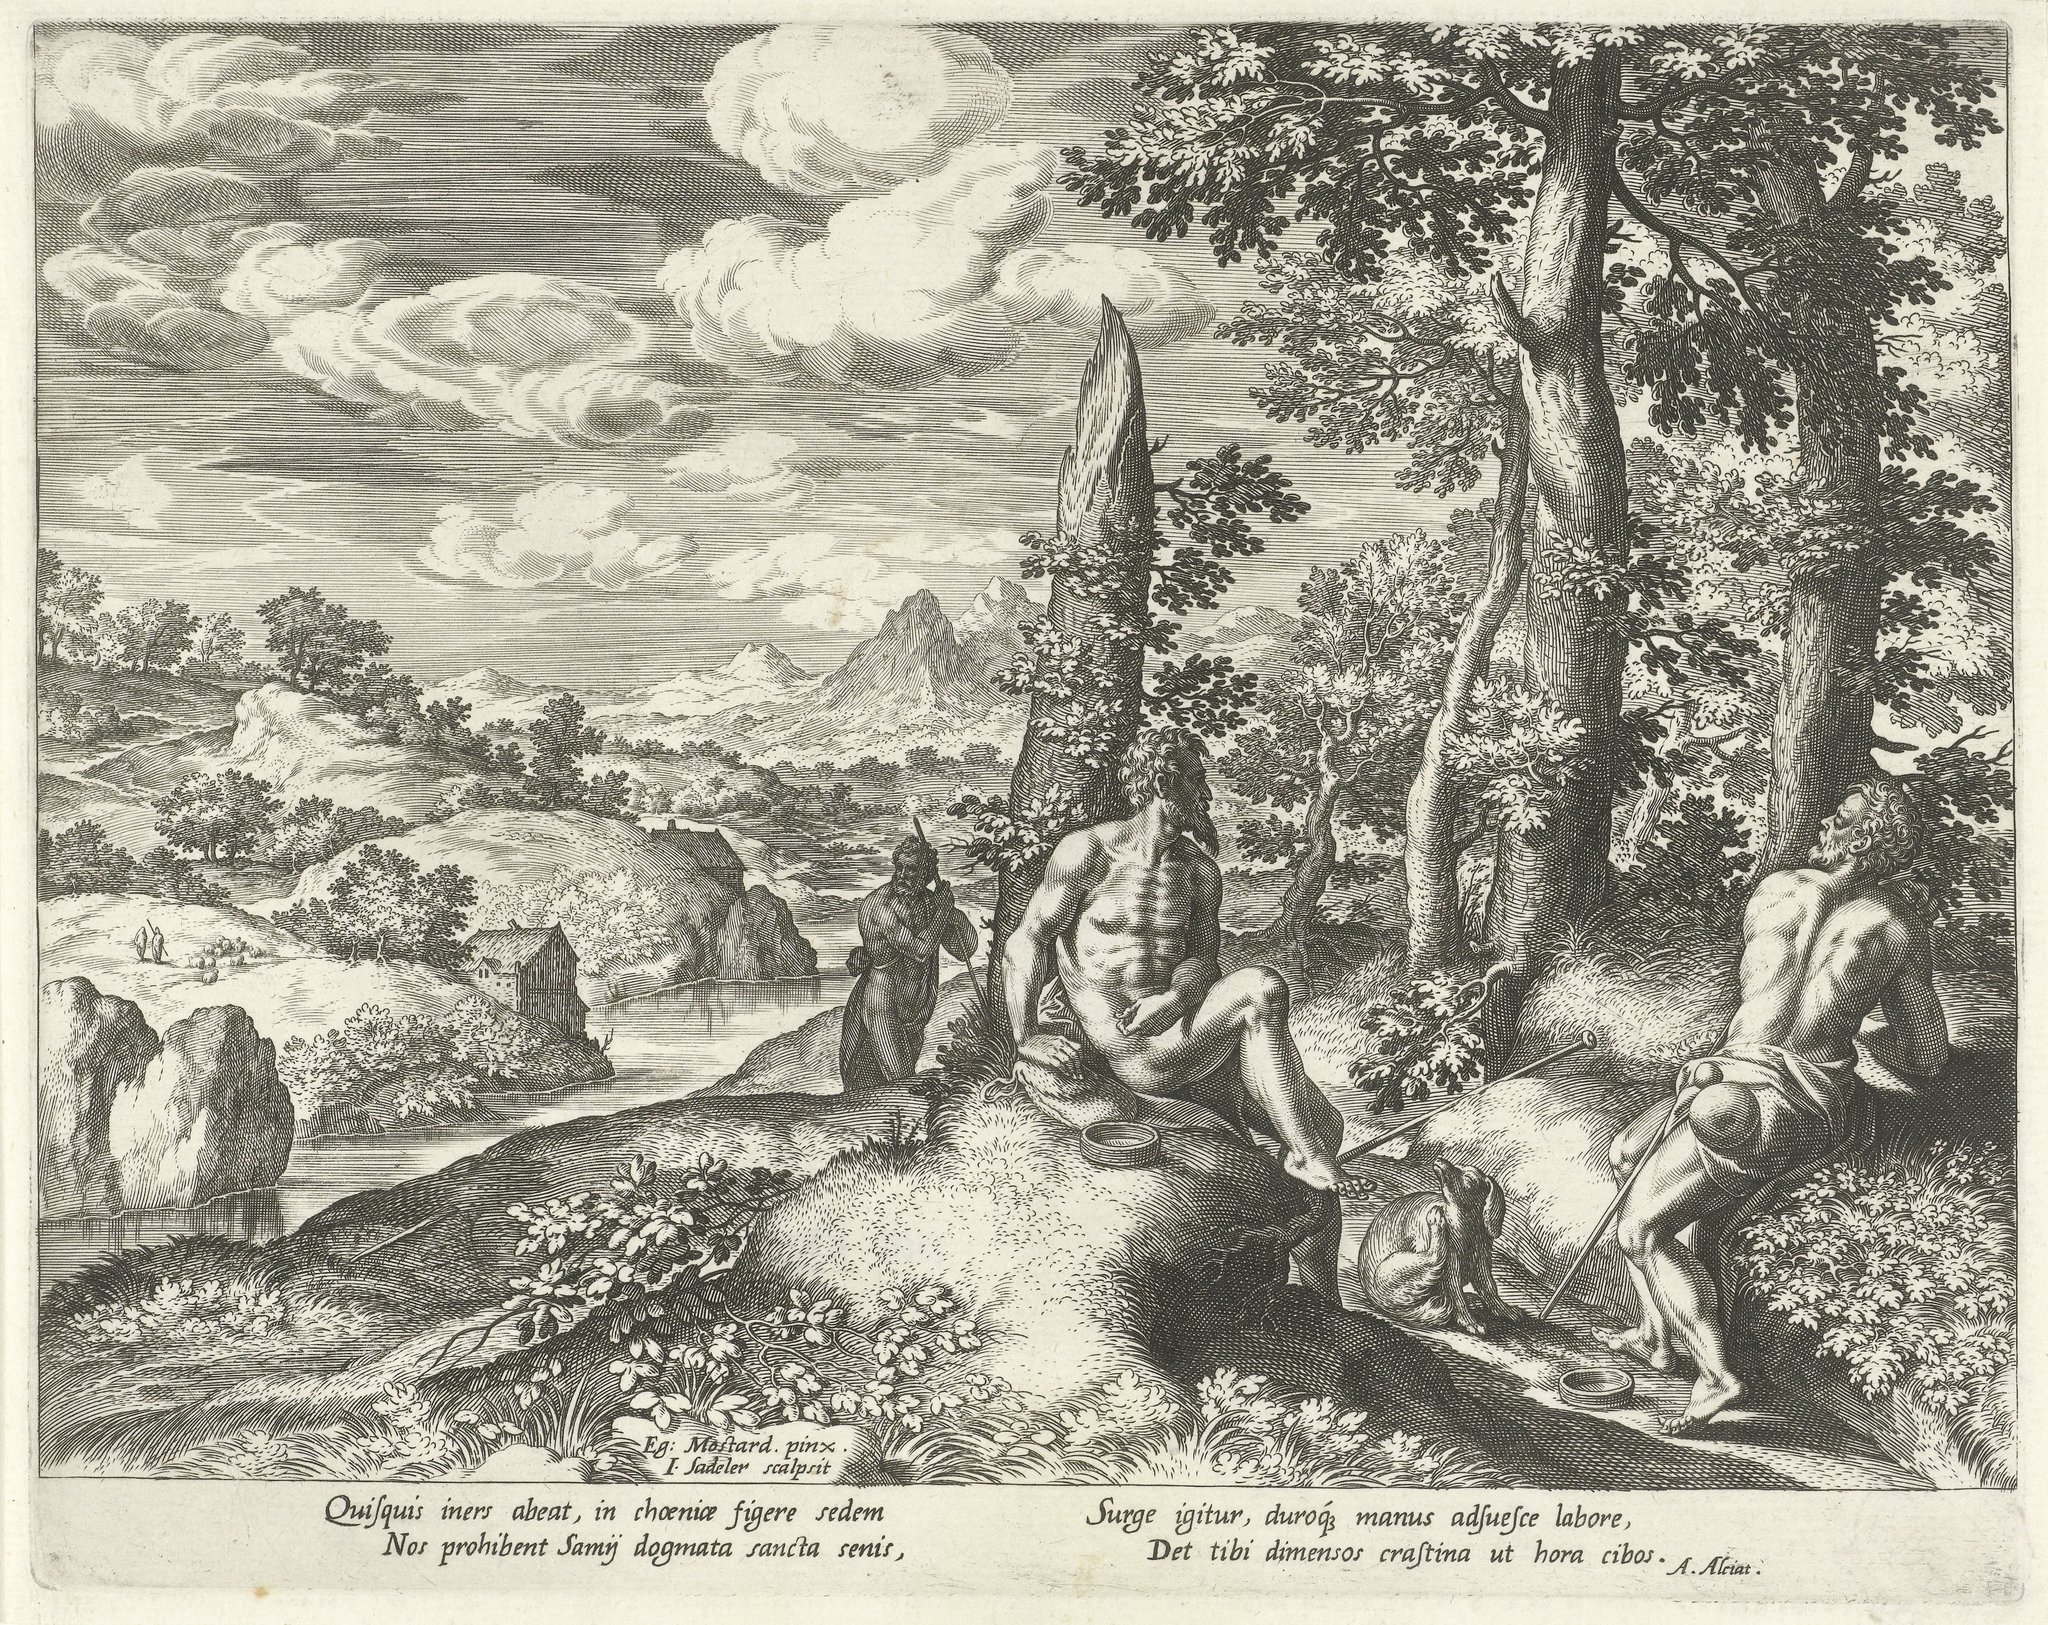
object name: print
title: Emblemen in een landschap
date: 1595-1600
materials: paper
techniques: engraving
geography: italy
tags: idleness; 'otio' (ripa) (+ emblematical representation of concept), sloth, indolence, 'acedia', 'desidia'; 'accidia' (ripa) ~ personification of one of the seven deadly sins, river, standing, leaning, sitting or lying with legs crossed, sitting on the ground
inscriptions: collector's mark: Lugt 240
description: Rivierlandschap met drie naakte mannen en een hond. De mannen zijn passief en werken niet. Een zit tegen een boomstronk geleund. Dit is de verbeelding van een embleem dat waarschuwt tegen luiheid. De prent heeft een Latijns onderschrift met het bijschrift van het embleem Desidiam abiiciendam van Andrea Alciati.